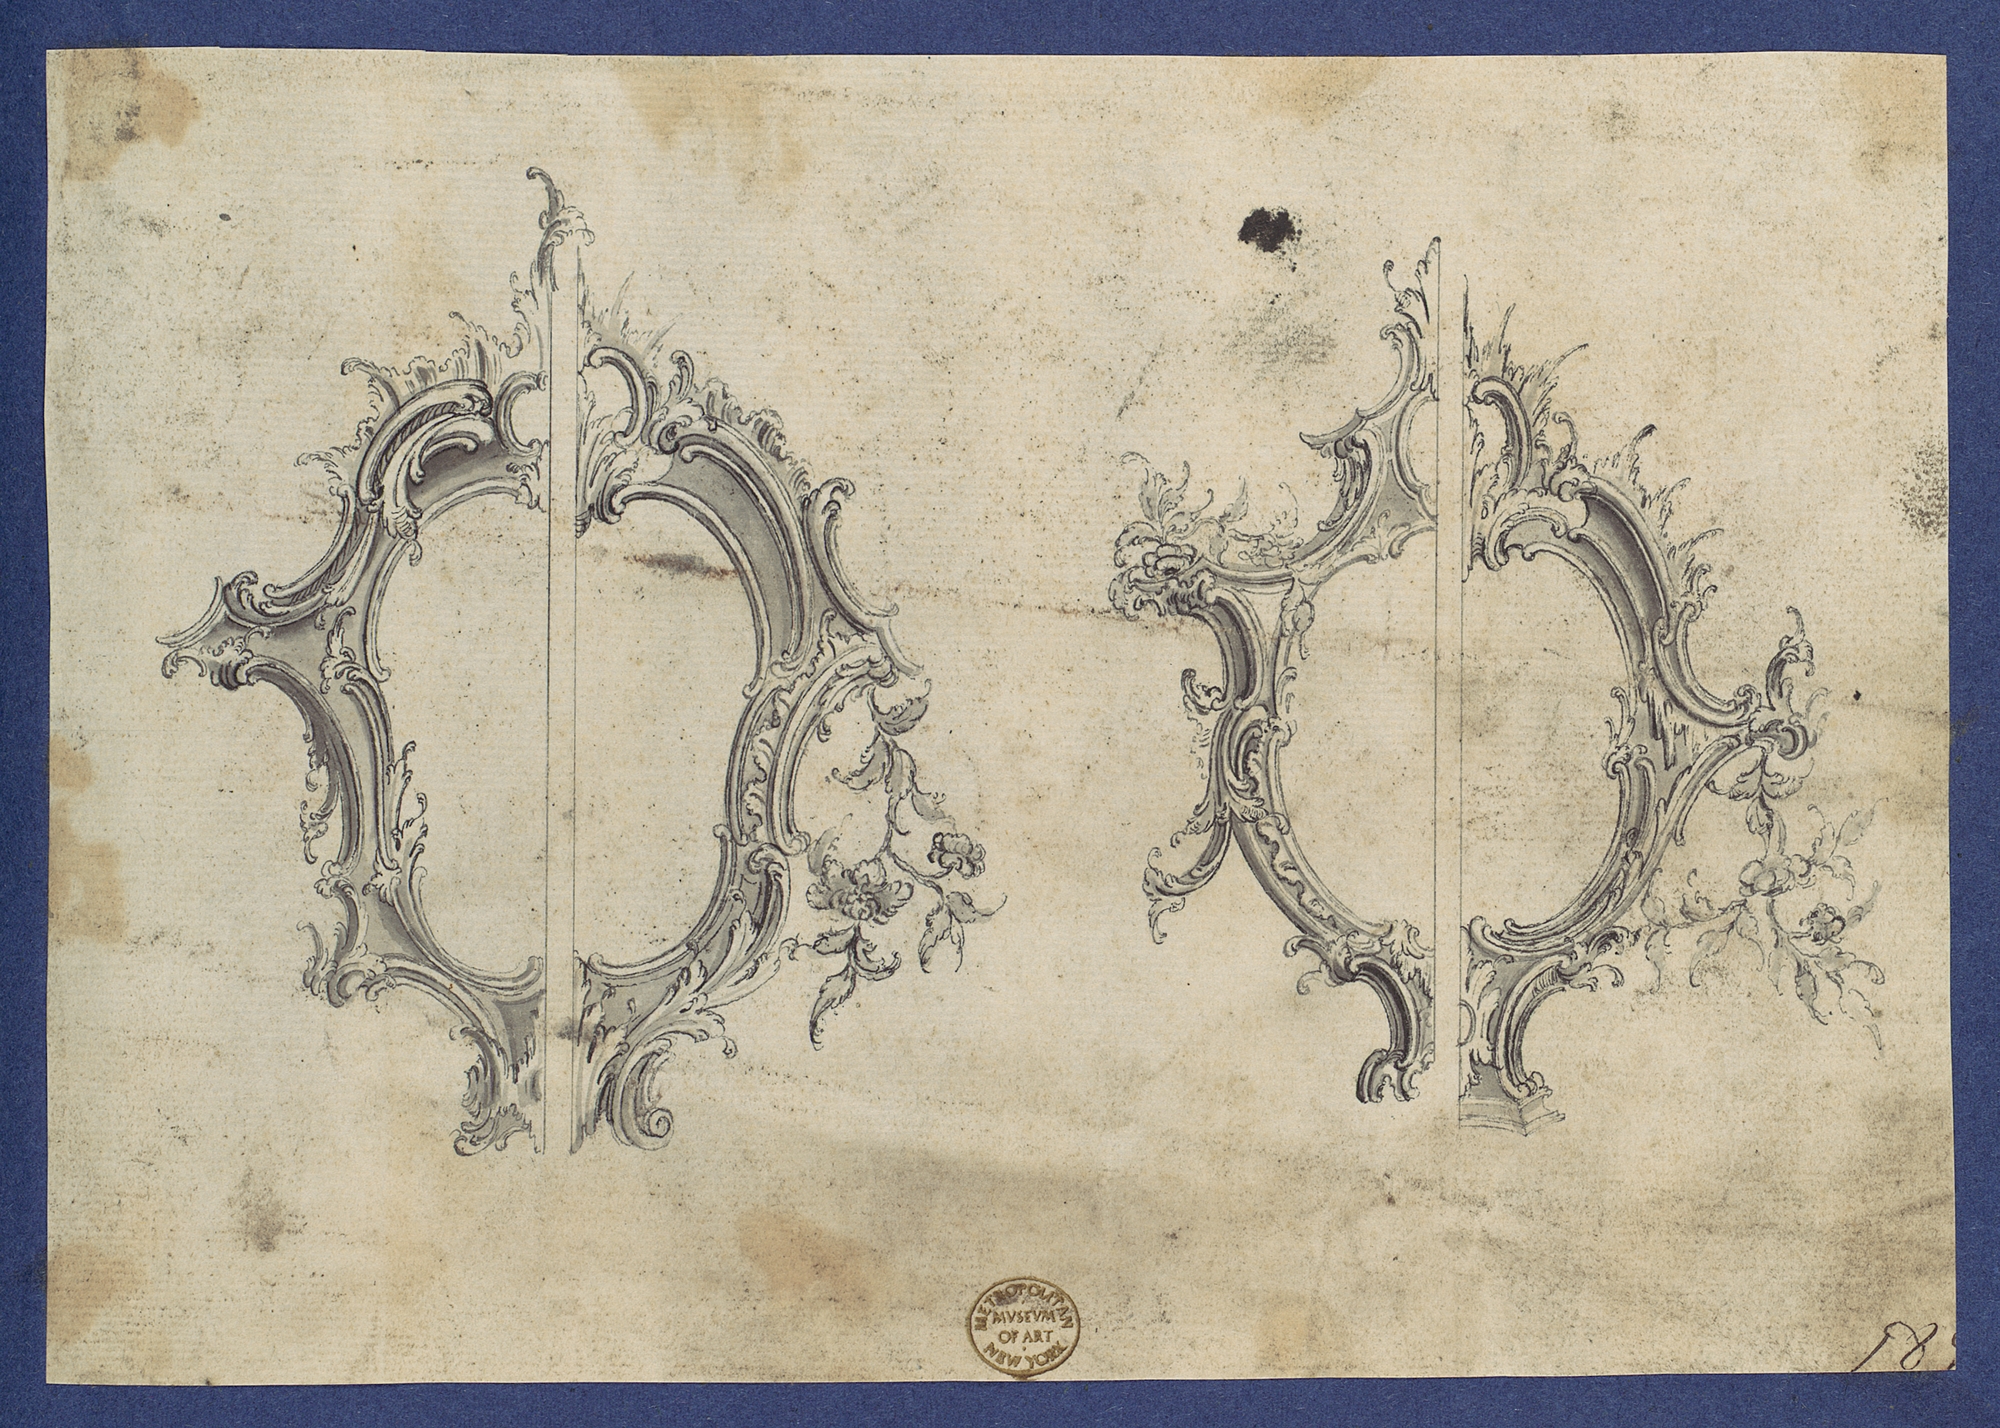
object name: drawing ornament architecture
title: Shields for Pediments, in Chippendale Drawings, Vol. I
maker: thomas chippendale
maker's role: artist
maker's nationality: british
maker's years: 1718-1779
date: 1754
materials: ink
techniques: wash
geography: london